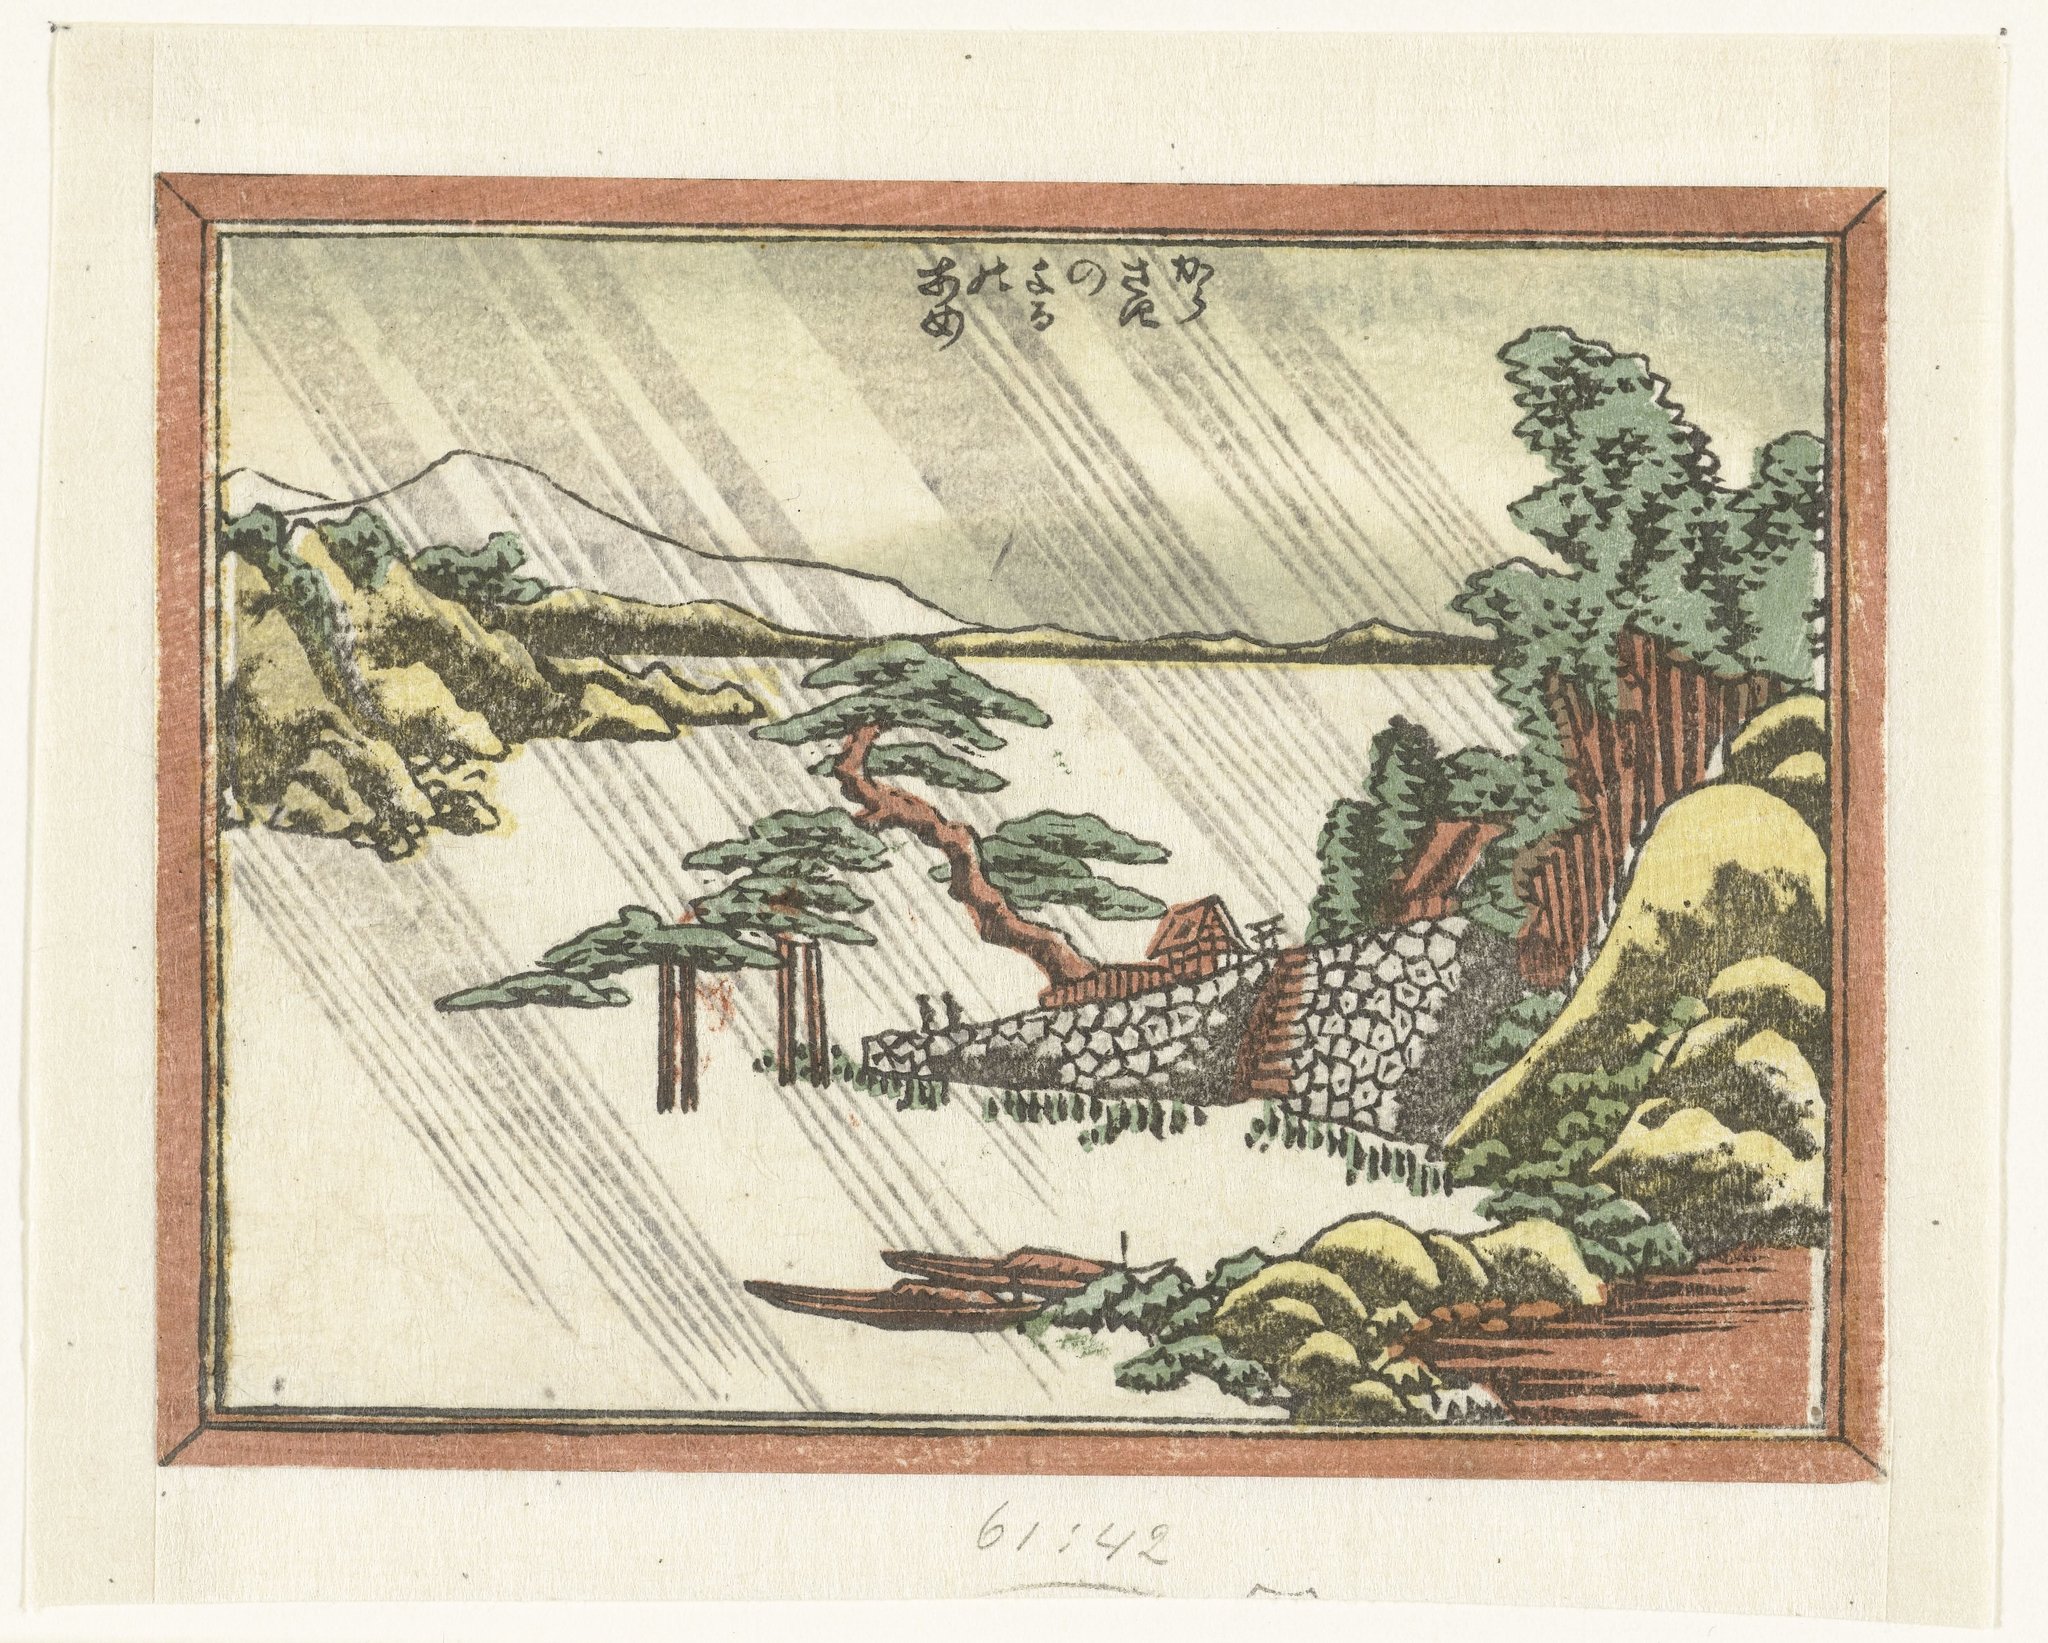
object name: print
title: Nachtelijke regen te Karasaki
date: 1809-1814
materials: paper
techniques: blind stamped, woodcut, nishiki e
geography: japan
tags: lake, rain, trees: pine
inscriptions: collector's mark: Lugt 2228, collector's mark: Lugt 2760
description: Regen landschap met pijnbomen langs een meer en twee aangelegde roeiboten; bergen op de achtergrond.